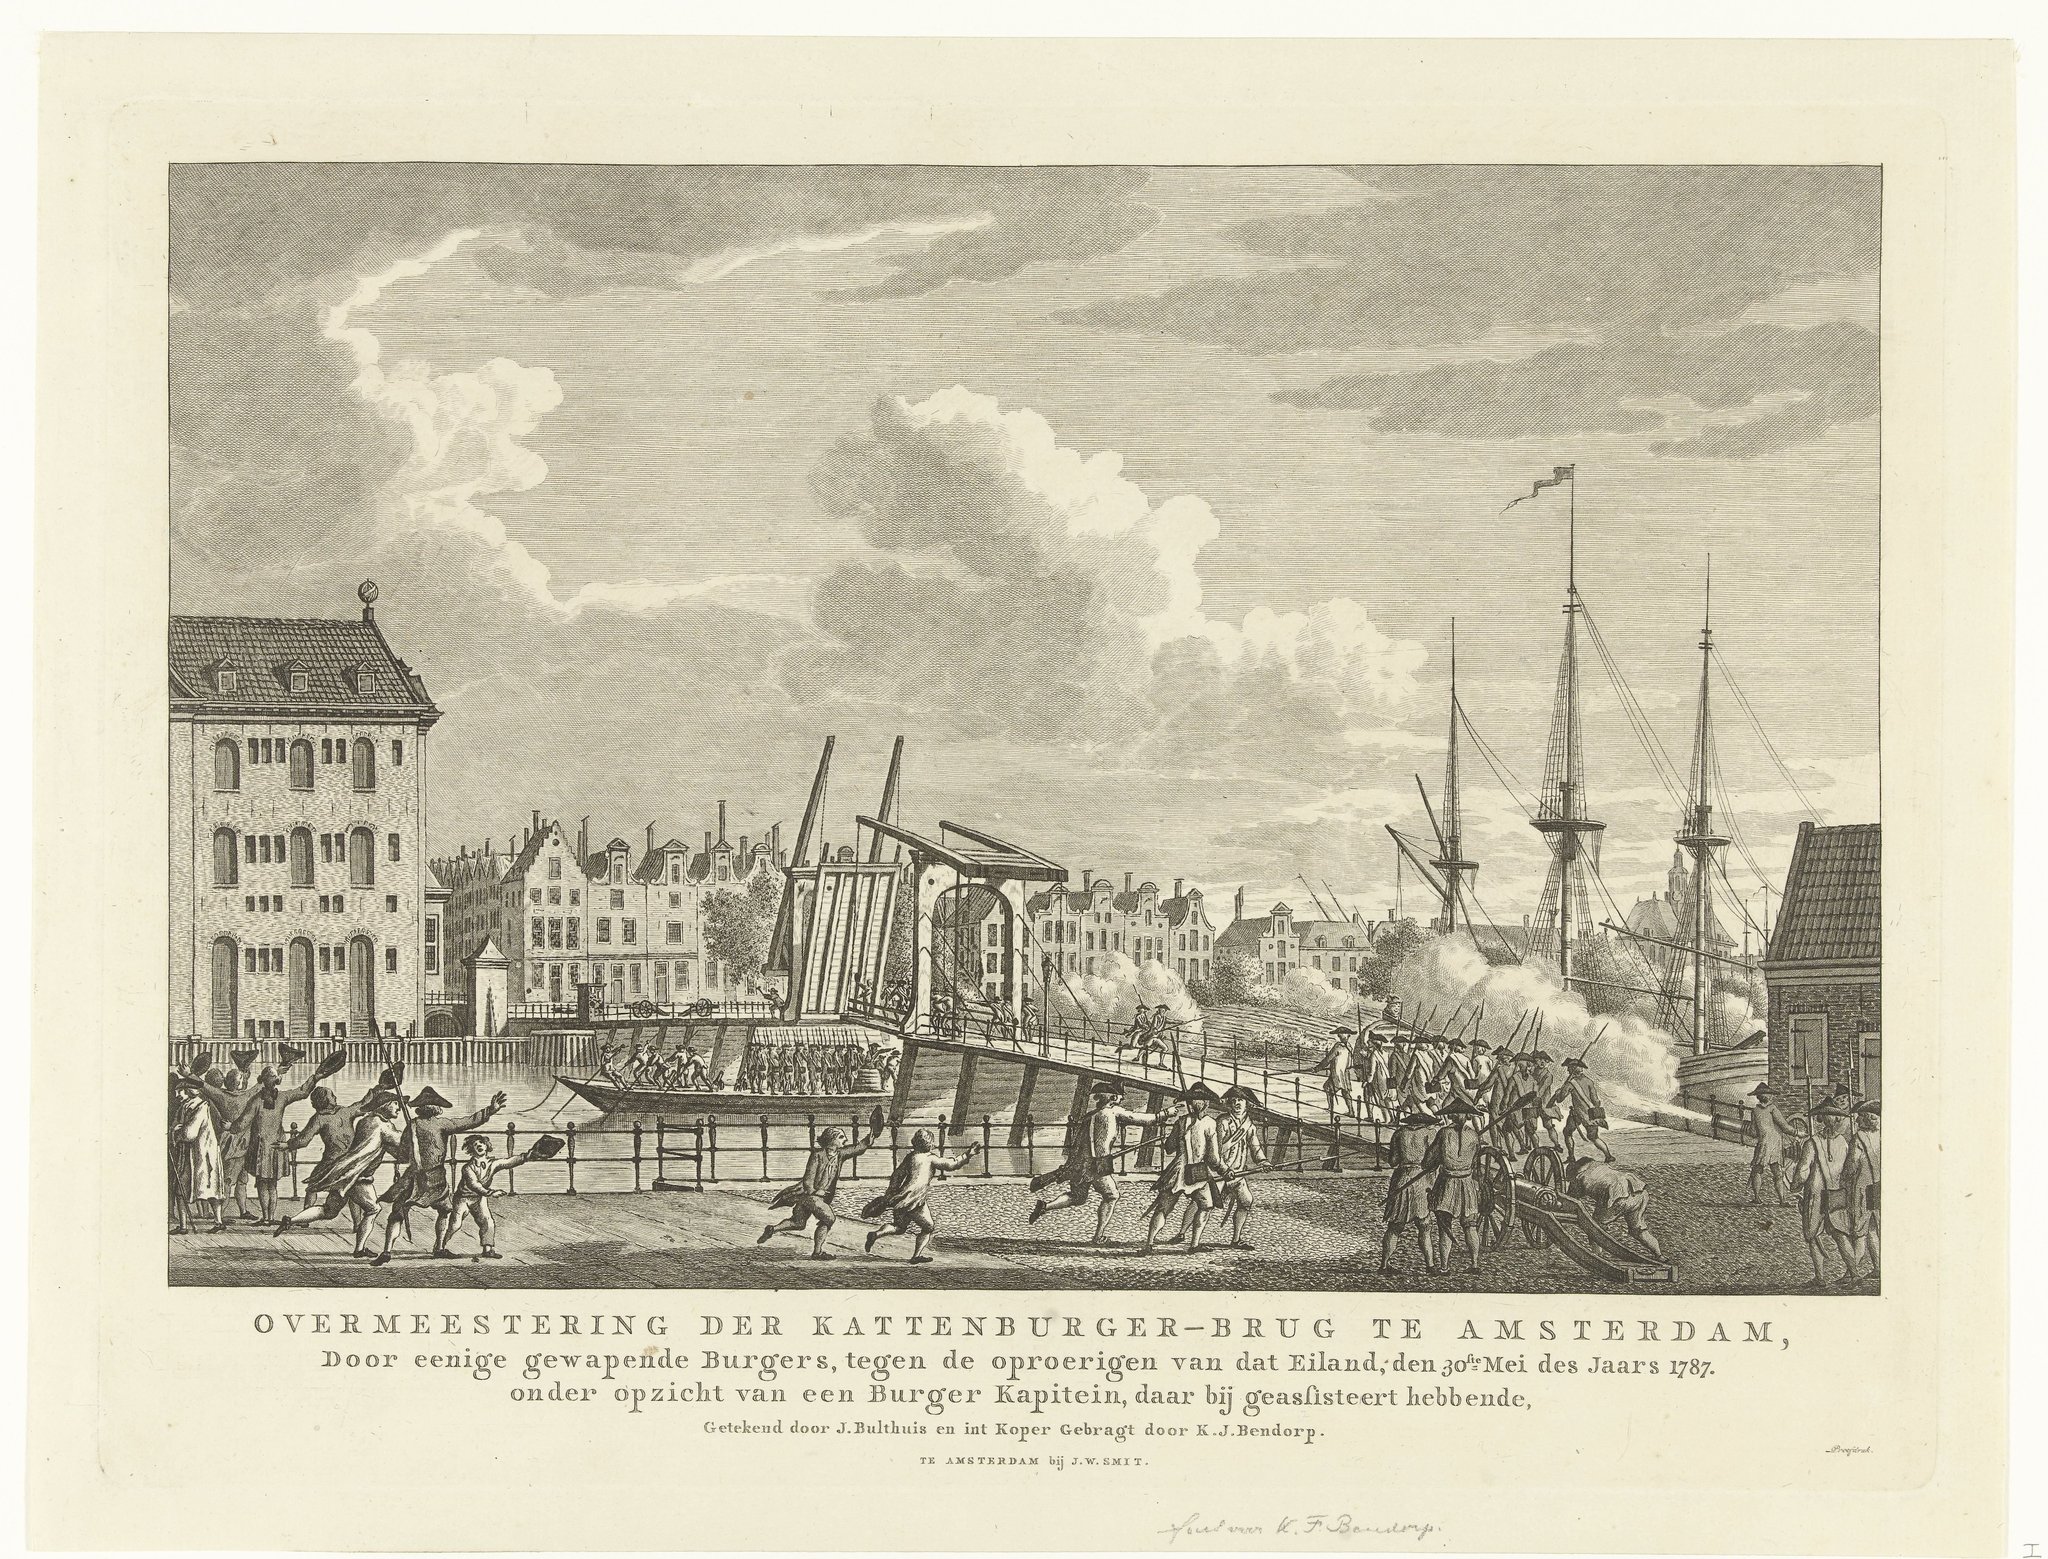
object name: print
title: Overmeestering van Kattenburg door gewapende Amsterdamse burgers op 30 mei 1787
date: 1787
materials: paper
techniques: etching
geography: amsterdam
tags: siege